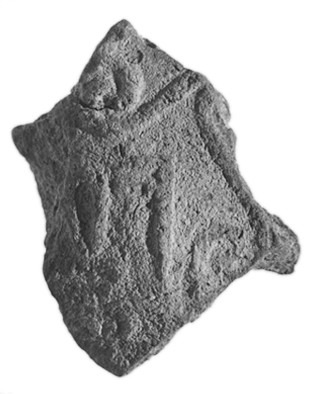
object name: sealing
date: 2030-1640 BCE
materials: clay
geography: egypt